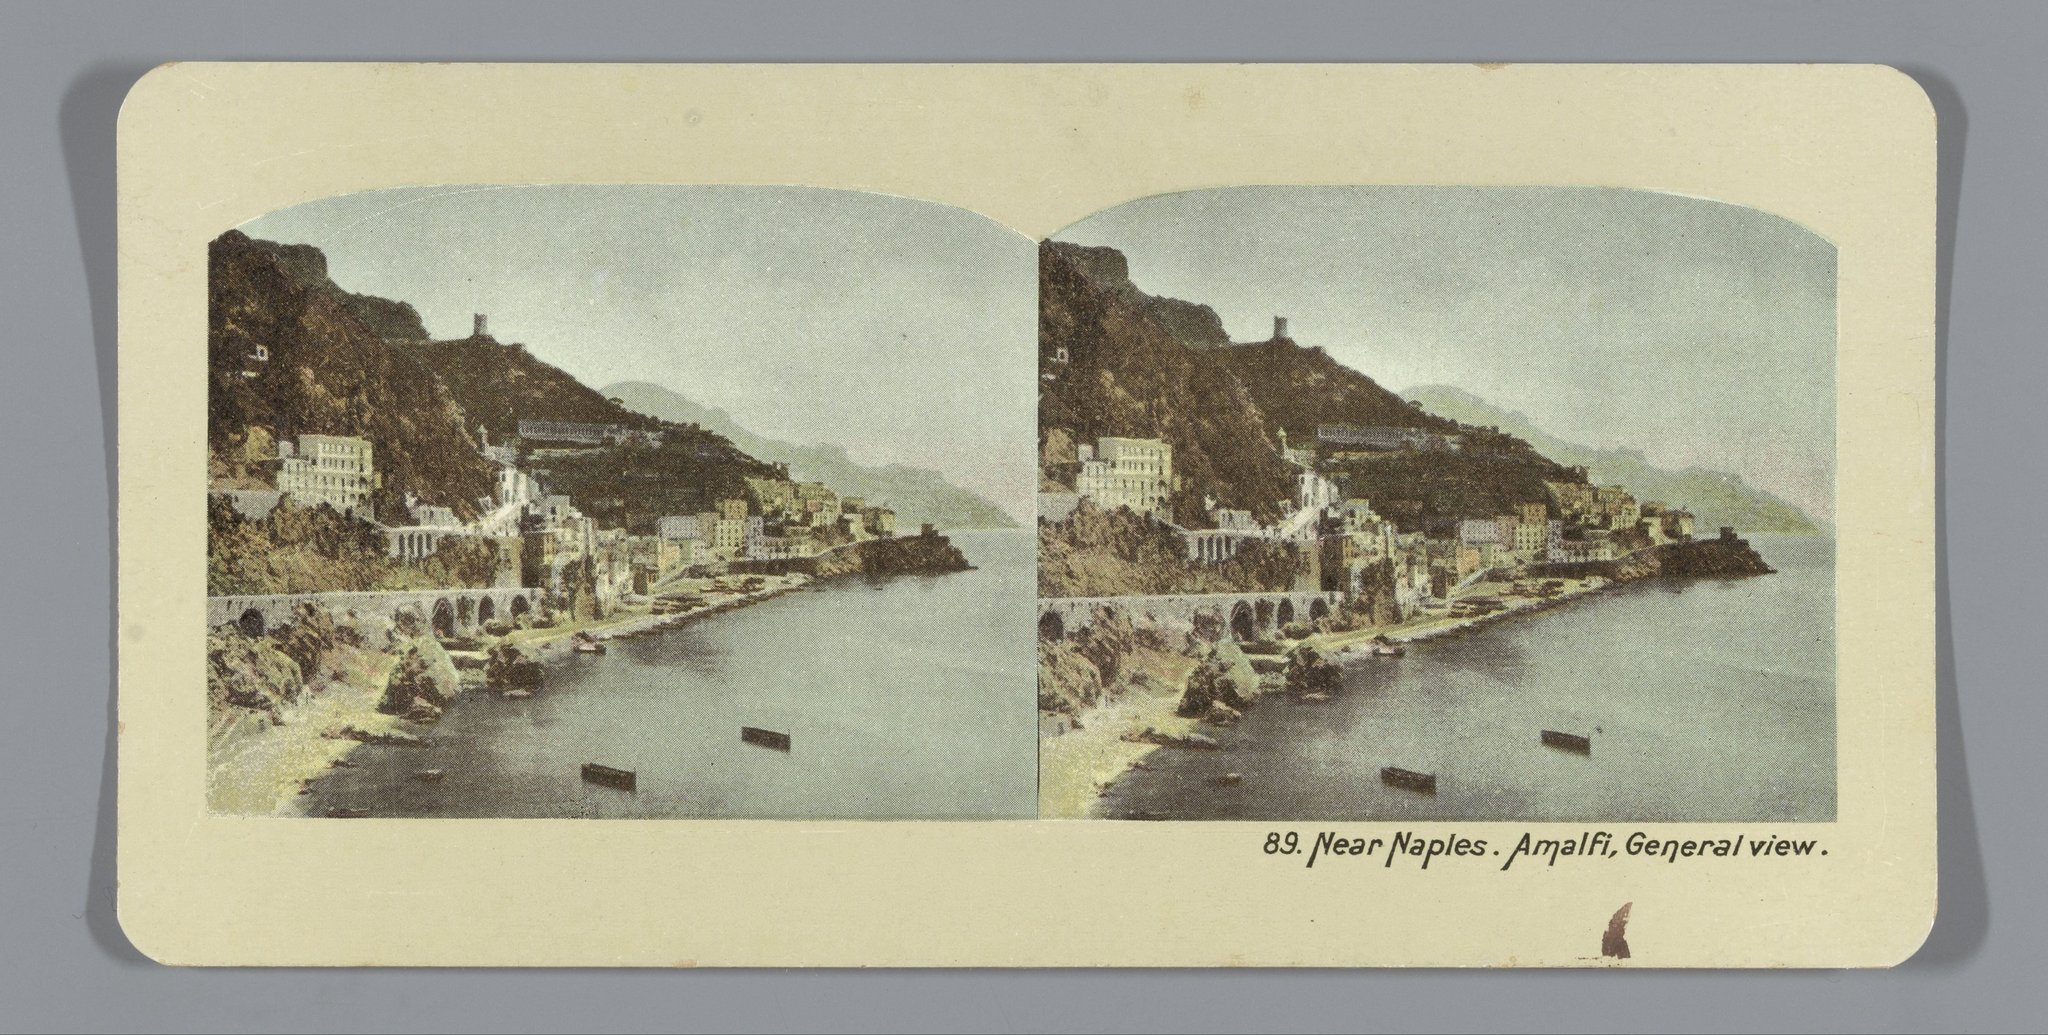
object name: stereograph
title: Near Naples. Amalfi, General view .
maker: Anonymous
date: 1900-1940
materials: cardboard, ink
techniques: offset printed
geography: campania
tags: city-view in general; 'veduta', rocky coast, amalfi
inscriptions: number: ‘89.’